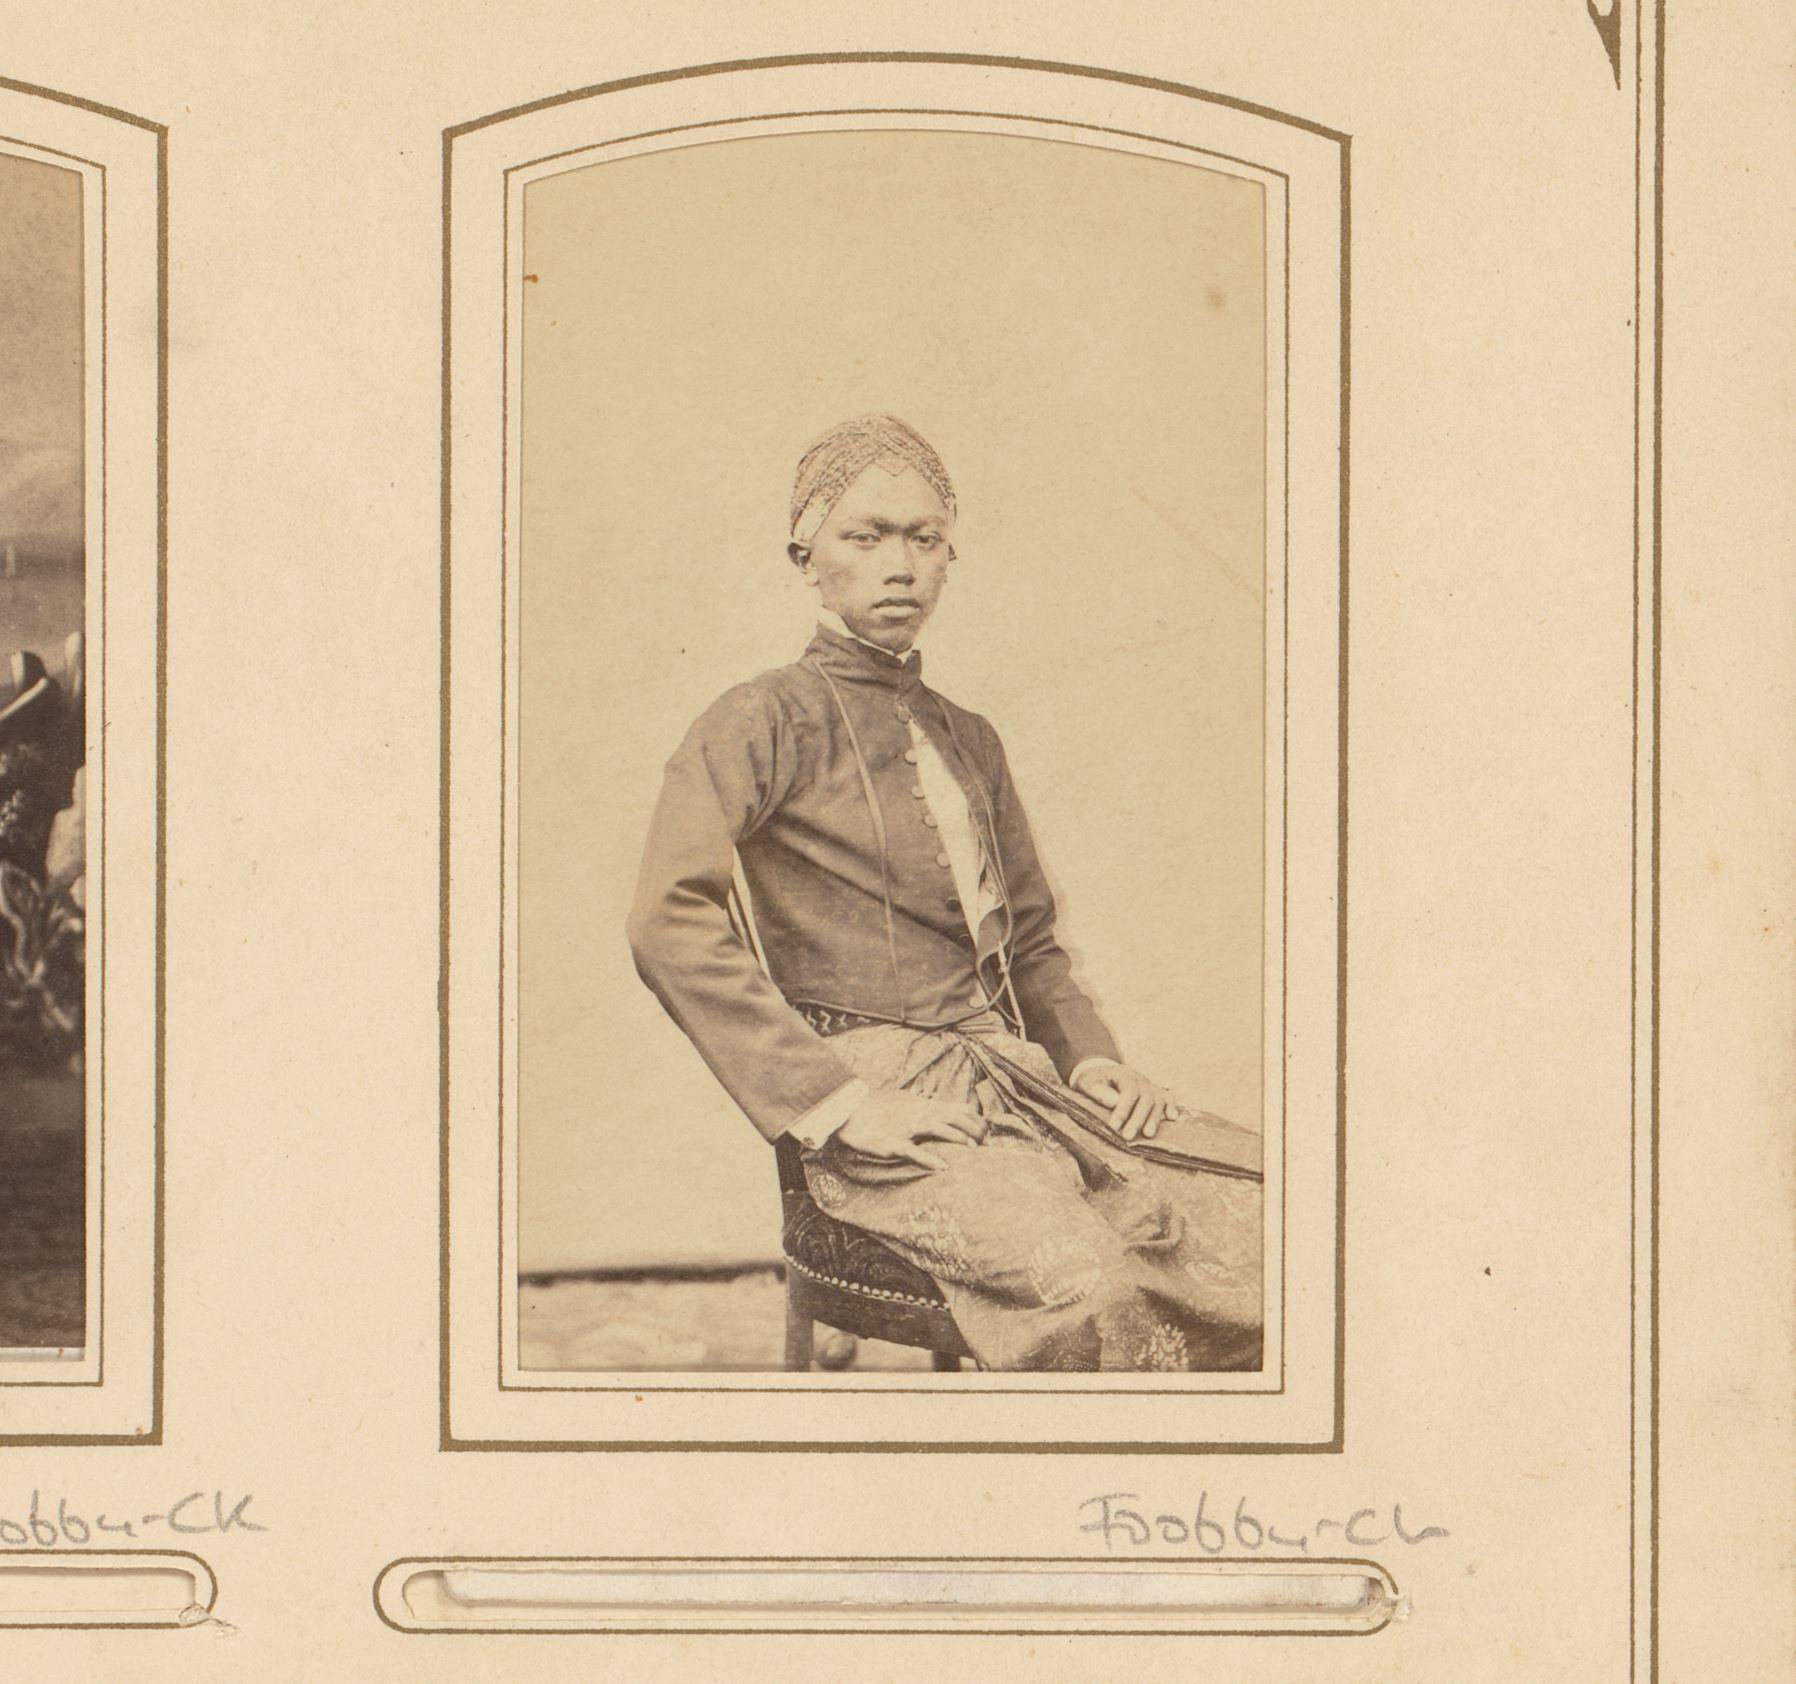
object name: carte de visite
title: Portret van een Indonesische jongeman in traditionele klederdracht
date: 1860-1880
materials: cardboard, photographic support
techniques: albumen print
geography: java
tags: historical persons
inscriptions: inscription: ‘Woodbury & Page/ Photographers/ Java’